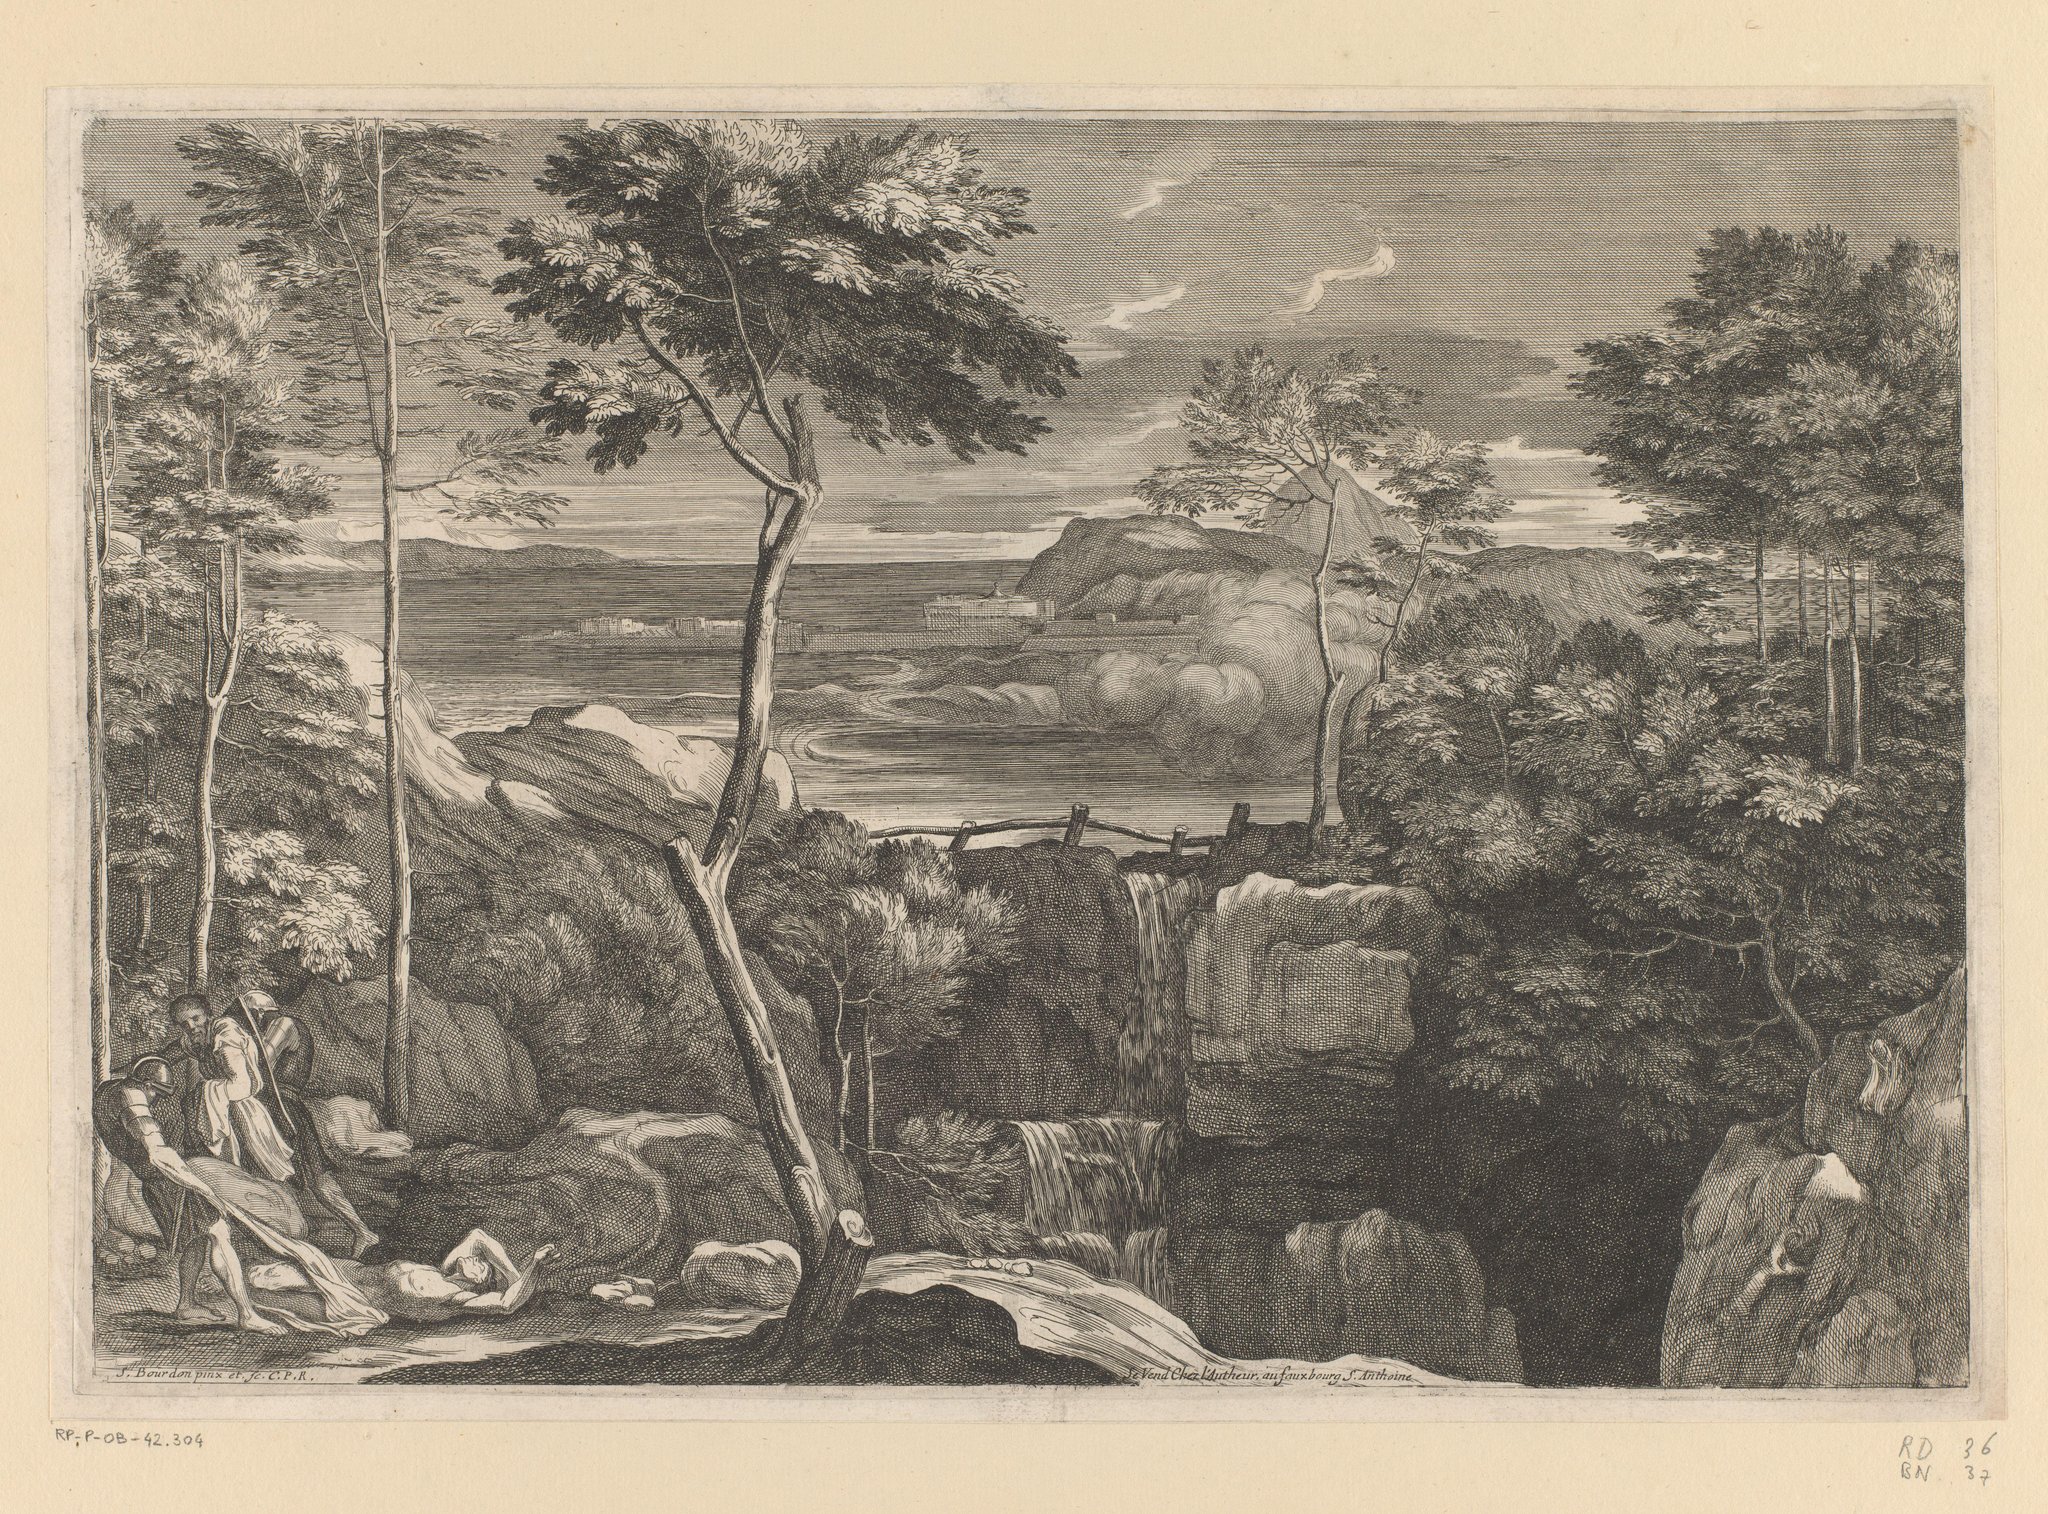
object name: print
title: Landschap met de parabel van de Barmhartige Samaritaan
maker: sébastien bourdon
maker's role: draughtsman, painter, print maker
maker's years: 1616-1671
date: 1626-1671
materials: paper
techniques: etching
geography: paris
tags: landscapes, the traveller is attacked by robbers ~ parable of the good samaritan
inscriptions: collector's mark: Lugt 240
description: Maakt deel uit van een serie van twaalf prenten van landschappen met enkele Bijbelse taferelen.